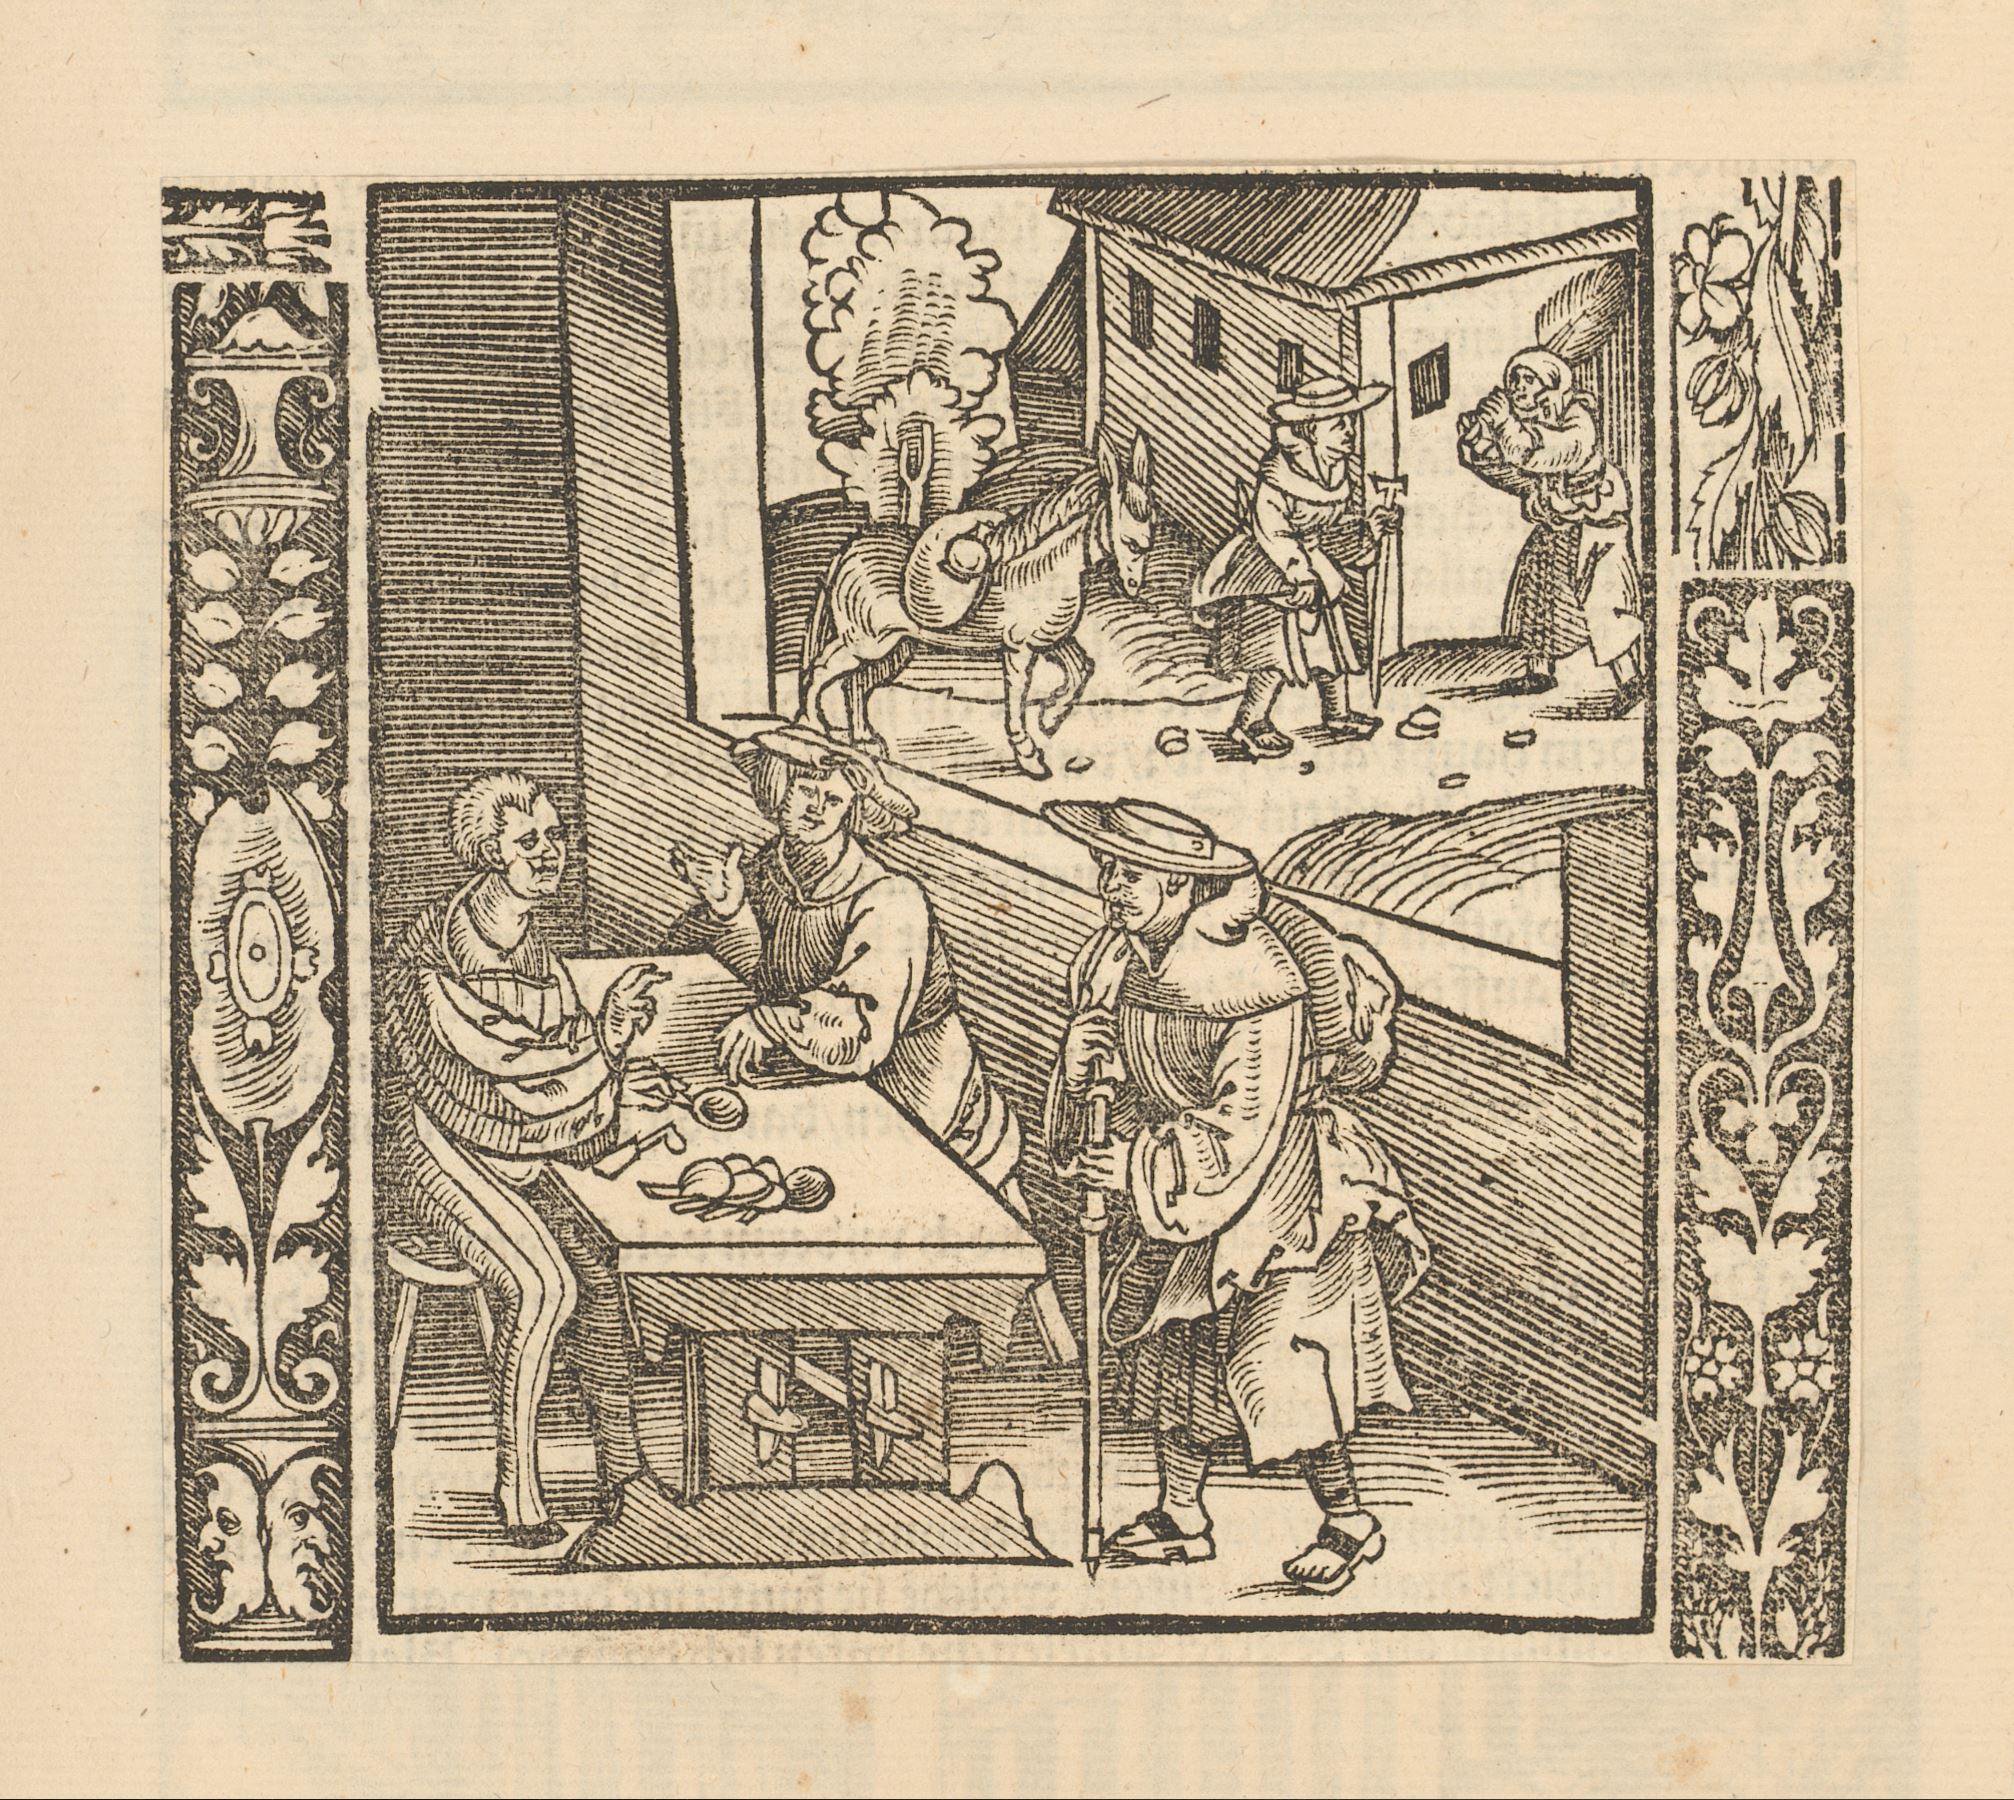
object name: album leaf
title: Aankomst van twee pelgrims in een dorp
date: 1490-1537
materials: paper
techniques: letterpress printing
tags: pilgrimage, pilgrim(s) under way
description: Twee ornamentele stroken met plantmotieven aan weerszijden. Prent maakt deel uit van een album.